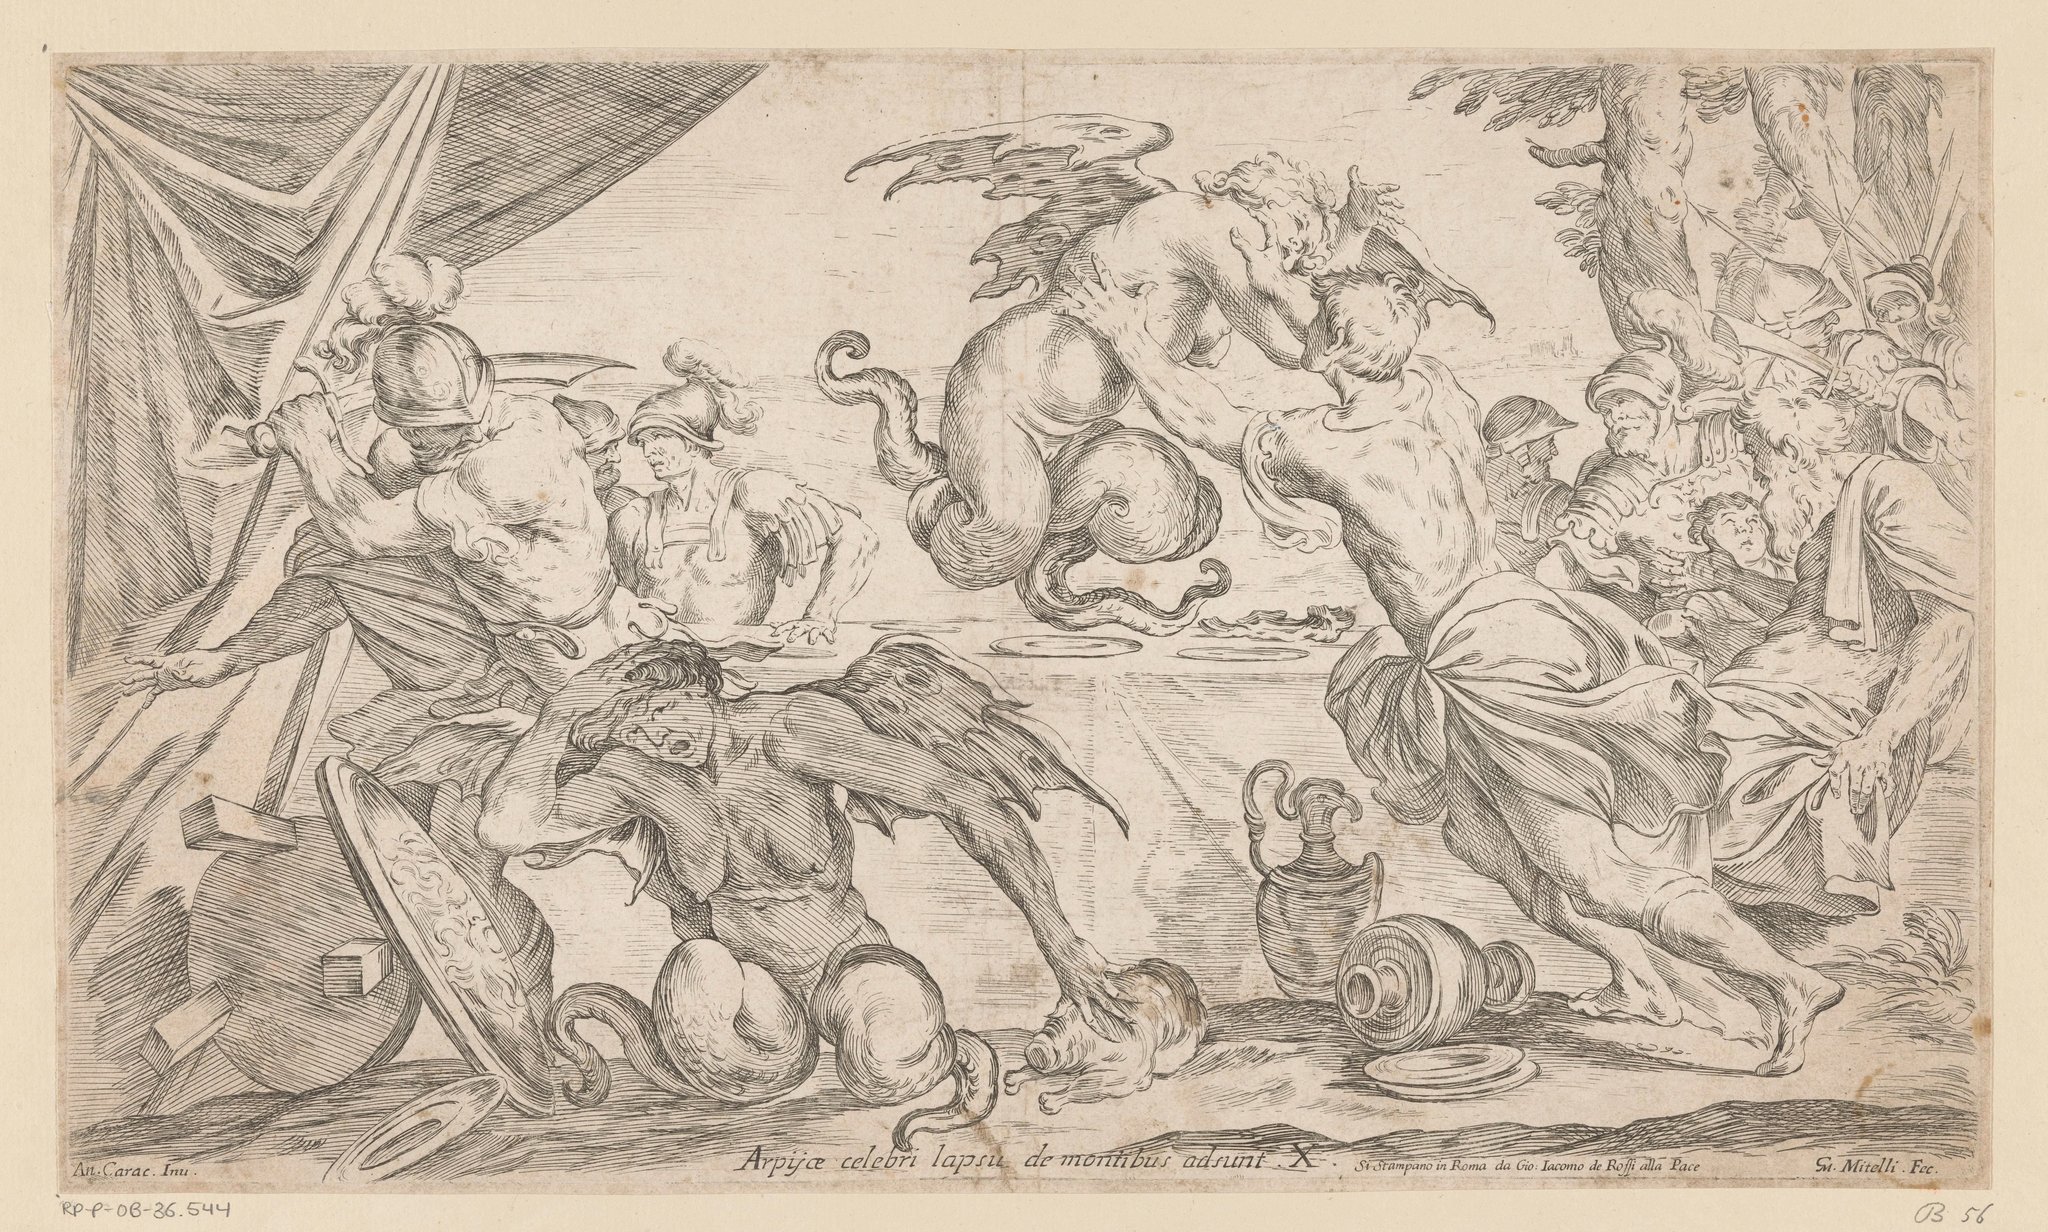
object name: print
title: Omzwervingen van Aeneas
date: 1663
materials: paper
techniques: etching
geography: italy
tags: stay of aeneas on the strophades islands: fight with the harpies that befoul the crew's food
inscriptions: collector's mark: Lugt 240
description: Aeneas en zijn metgezellen worden gestoord tijdens een maaltijd door Harpijen. Er ontstaat een gevecht tussen de soldaten en de Harpijen. Genummerd: X.